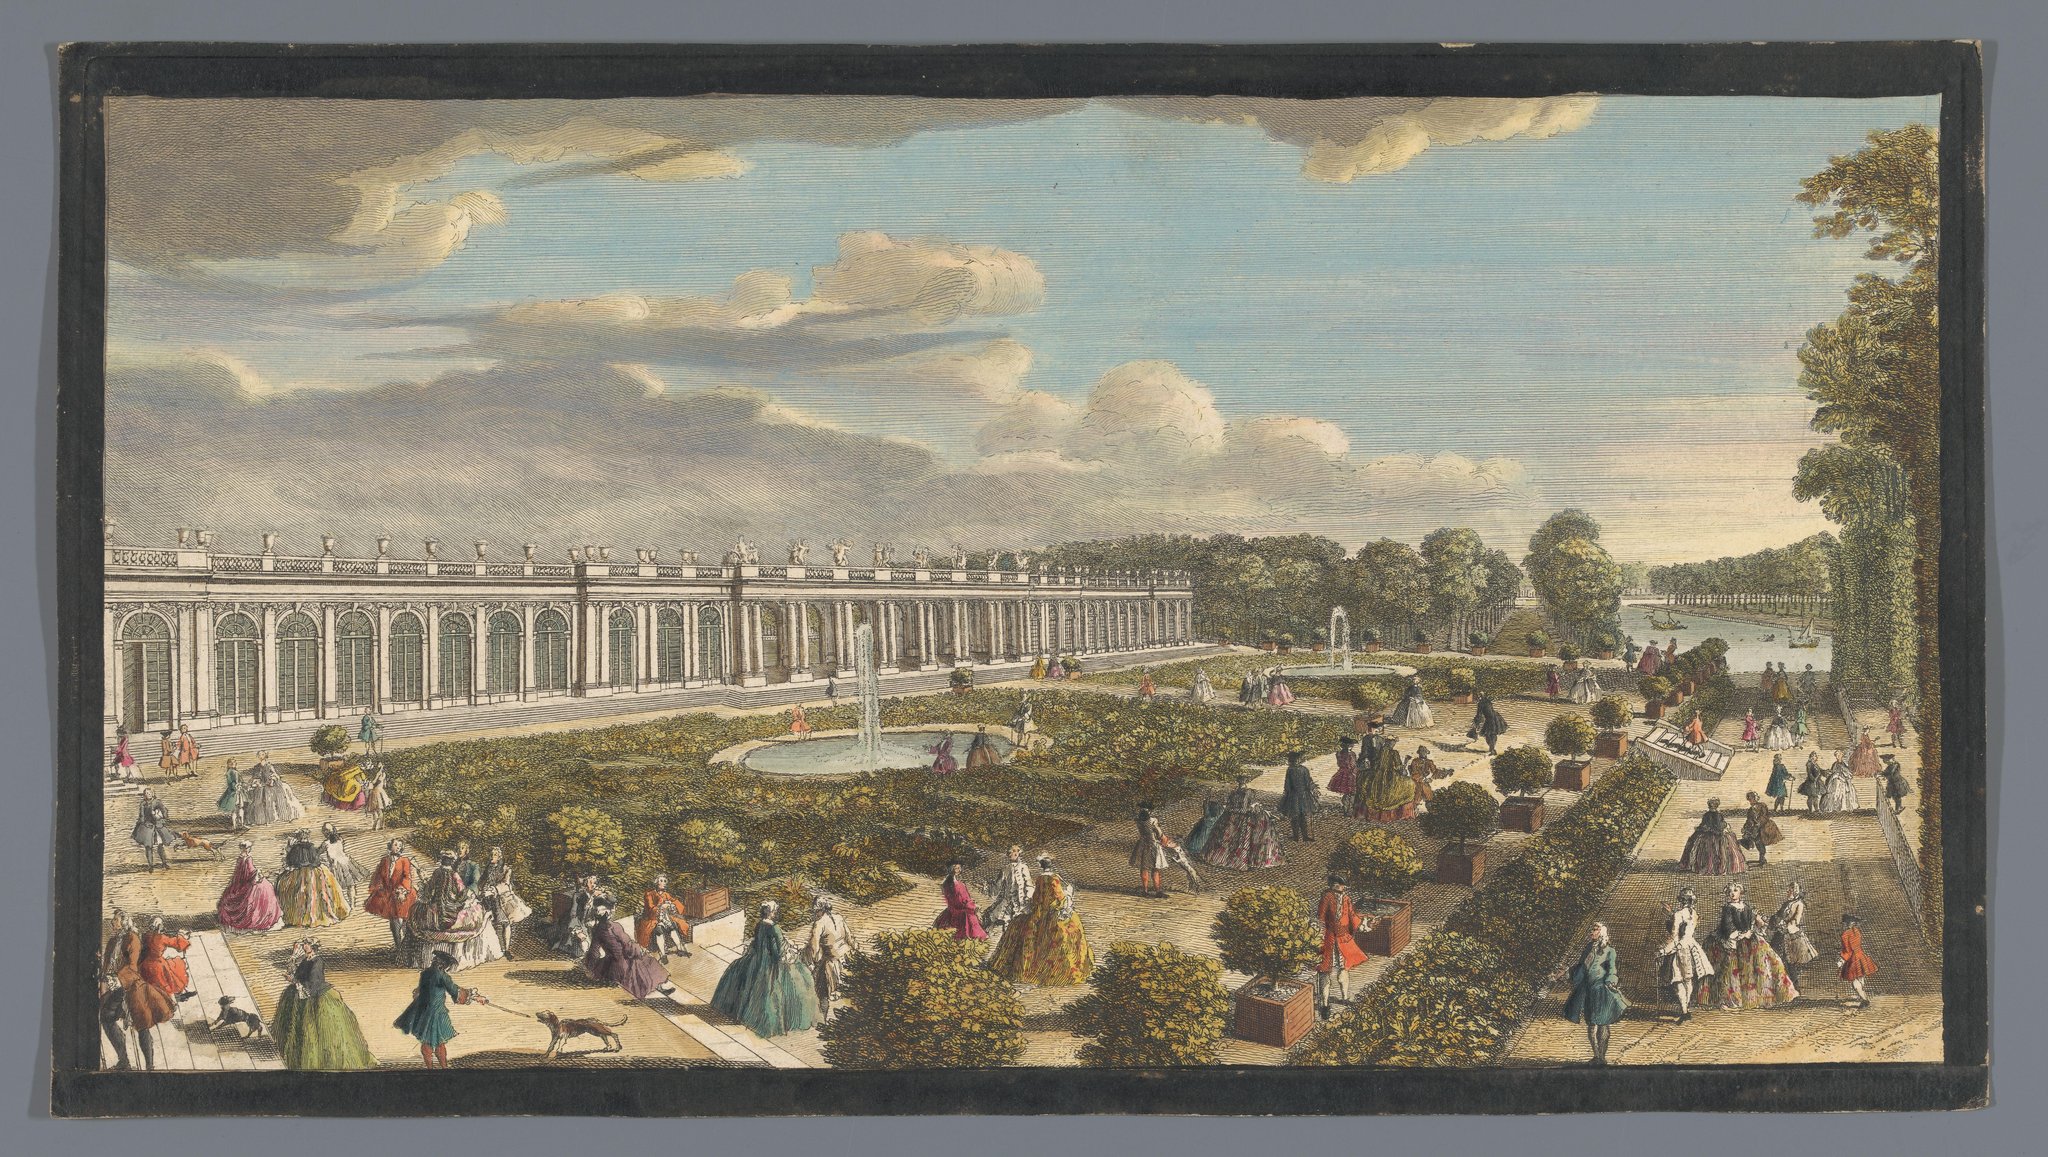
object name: print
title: A view of the Palace of Trianõ towards the flower garden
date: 1700-1761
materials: cardboard, paper, watercolor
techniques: brush, etching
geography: london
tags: garden, garden fountain, ornamental plants, garden buildings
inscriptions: inscription: ‘Fo 23 B4’